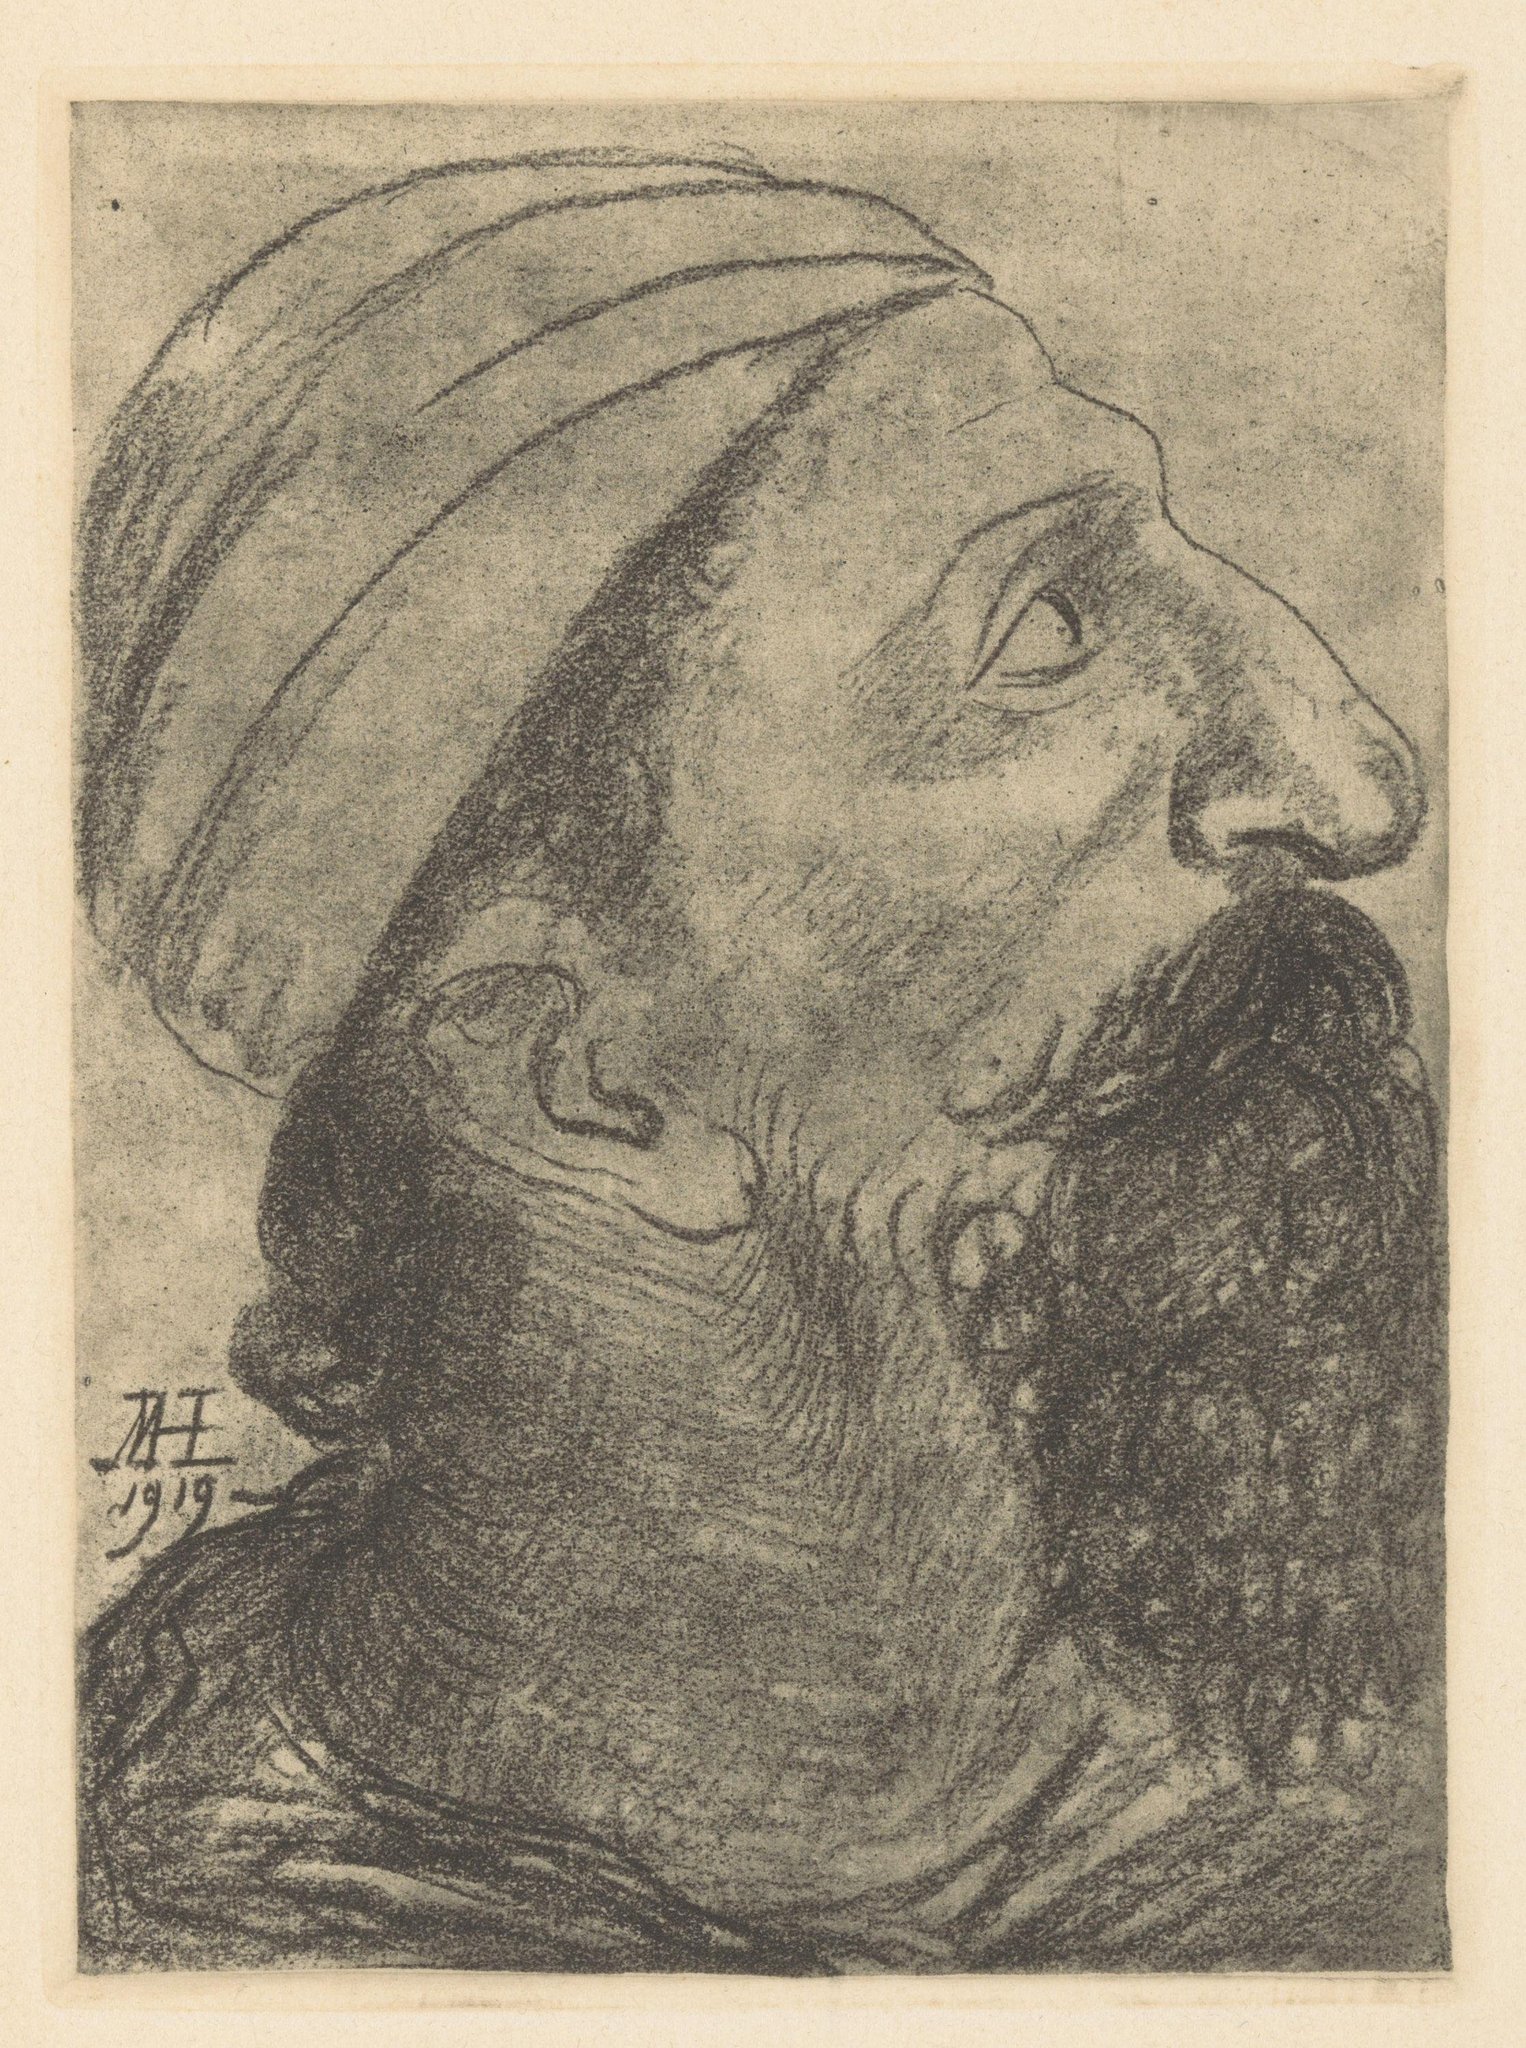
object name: print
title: Man met baard en muts en profil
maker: marius holleman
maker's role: draughtsman, print maker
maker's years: 1878-1926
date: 1919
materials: paper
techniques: etching, intaglio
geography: groningen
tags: head-gear: hat, beard, looking upwards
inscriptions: collector's mark: Lugt 2228